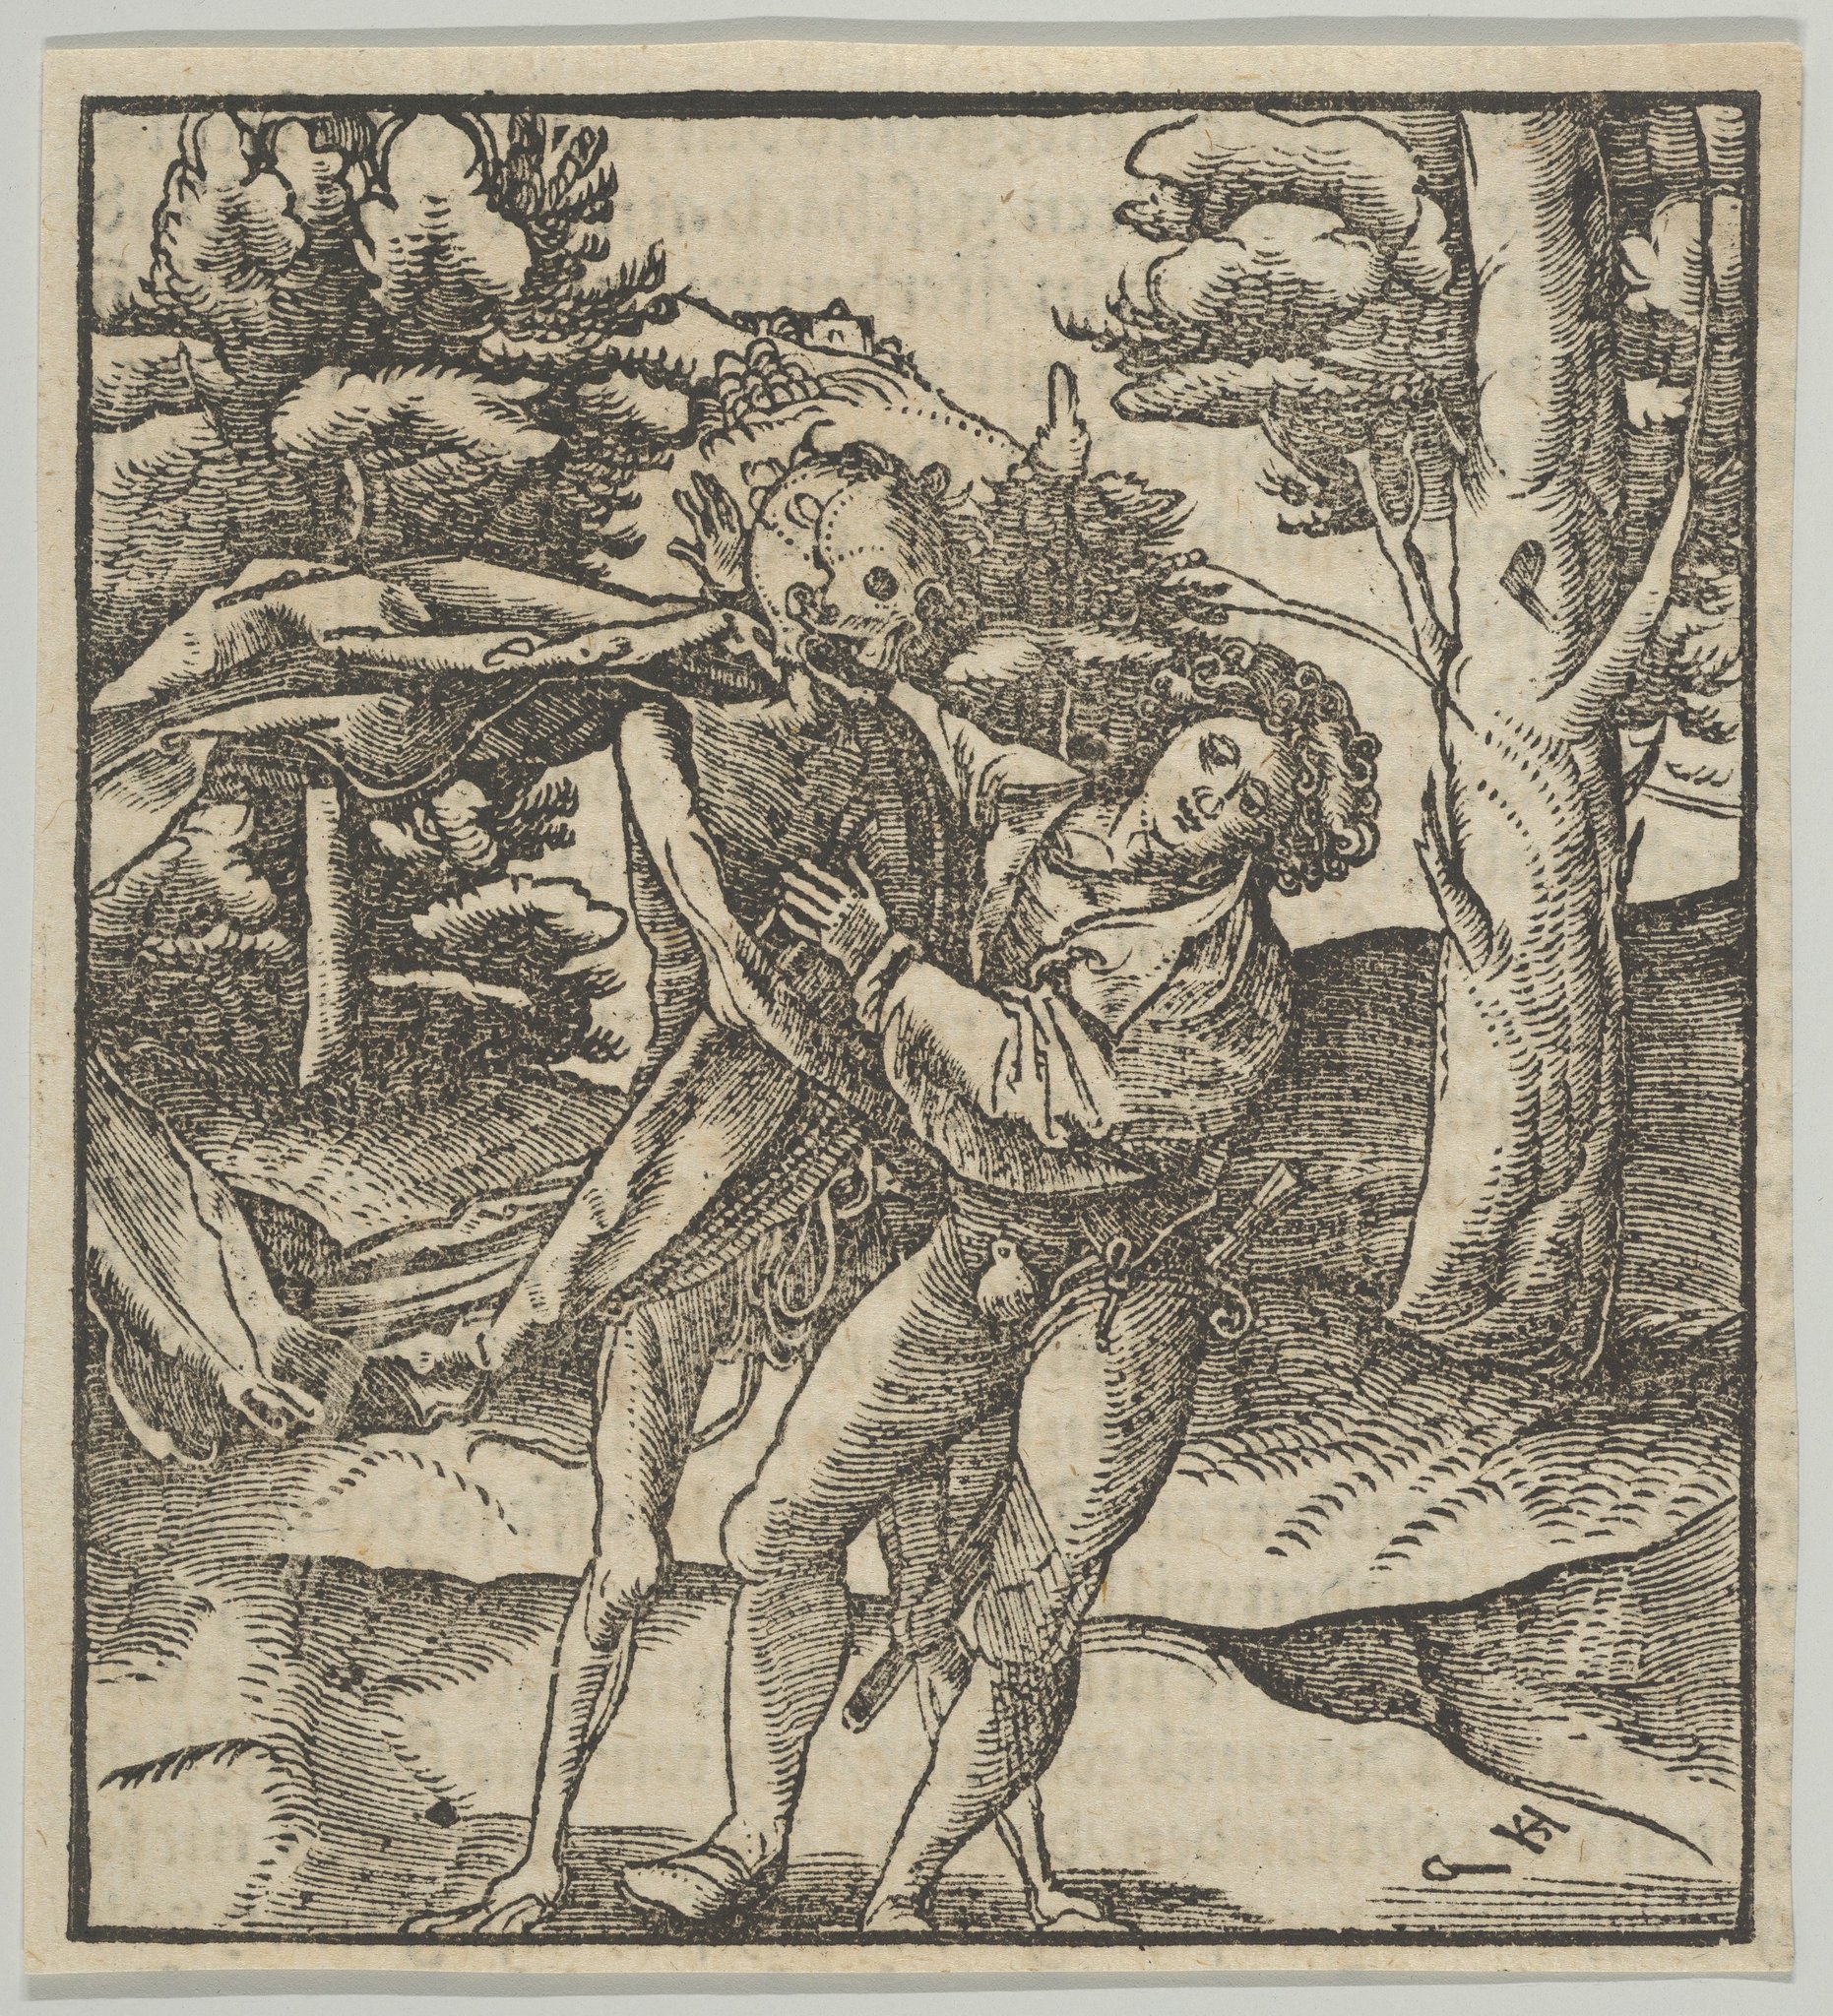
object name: print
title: A Young Man Seized by Death, from Hymmelwagen auff dem, wer wol lebt...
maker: hans schäufelein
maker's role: artist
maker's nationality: german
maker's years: 1480-1540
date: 1517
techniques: woodcut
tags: men,death